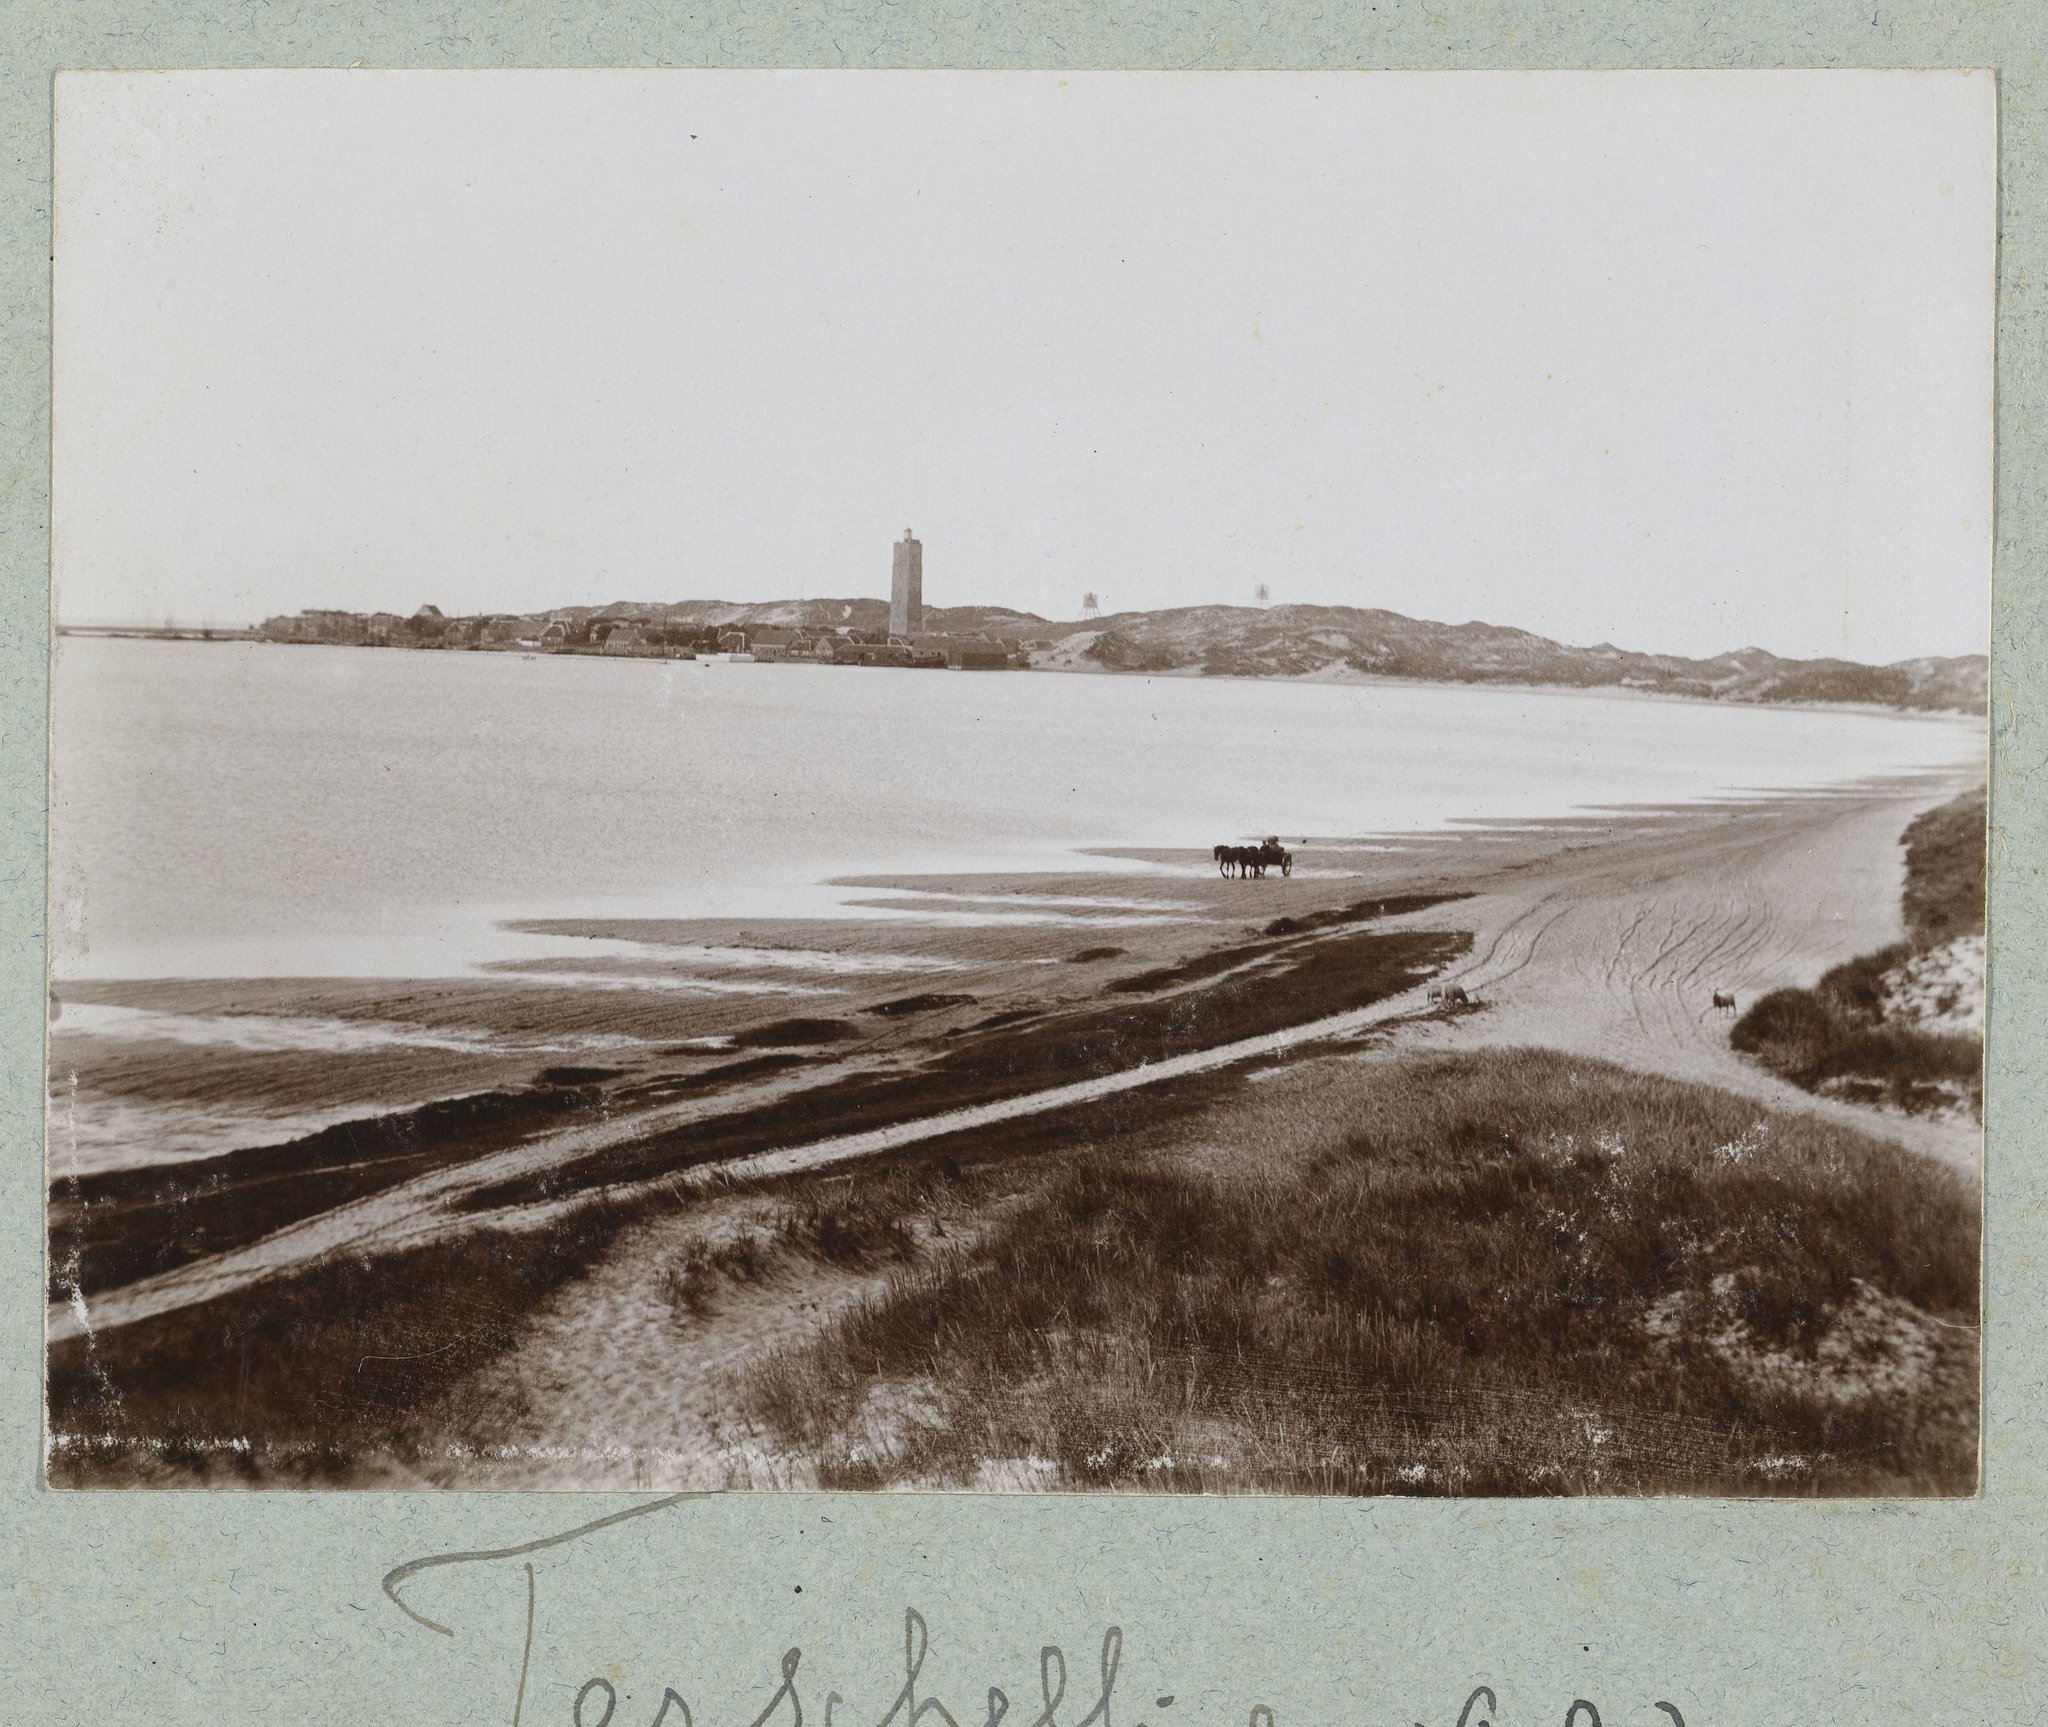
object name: photograph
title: Photographieën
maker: frits freerks fontein fz.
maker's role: fotograaf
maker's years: 1882-1928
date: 1902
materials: cardboard, paper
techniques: gelatin silver print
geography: england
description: Op de achtergrond is een vuurtoren zichtbaar. Foto uit album 'Photographieën".